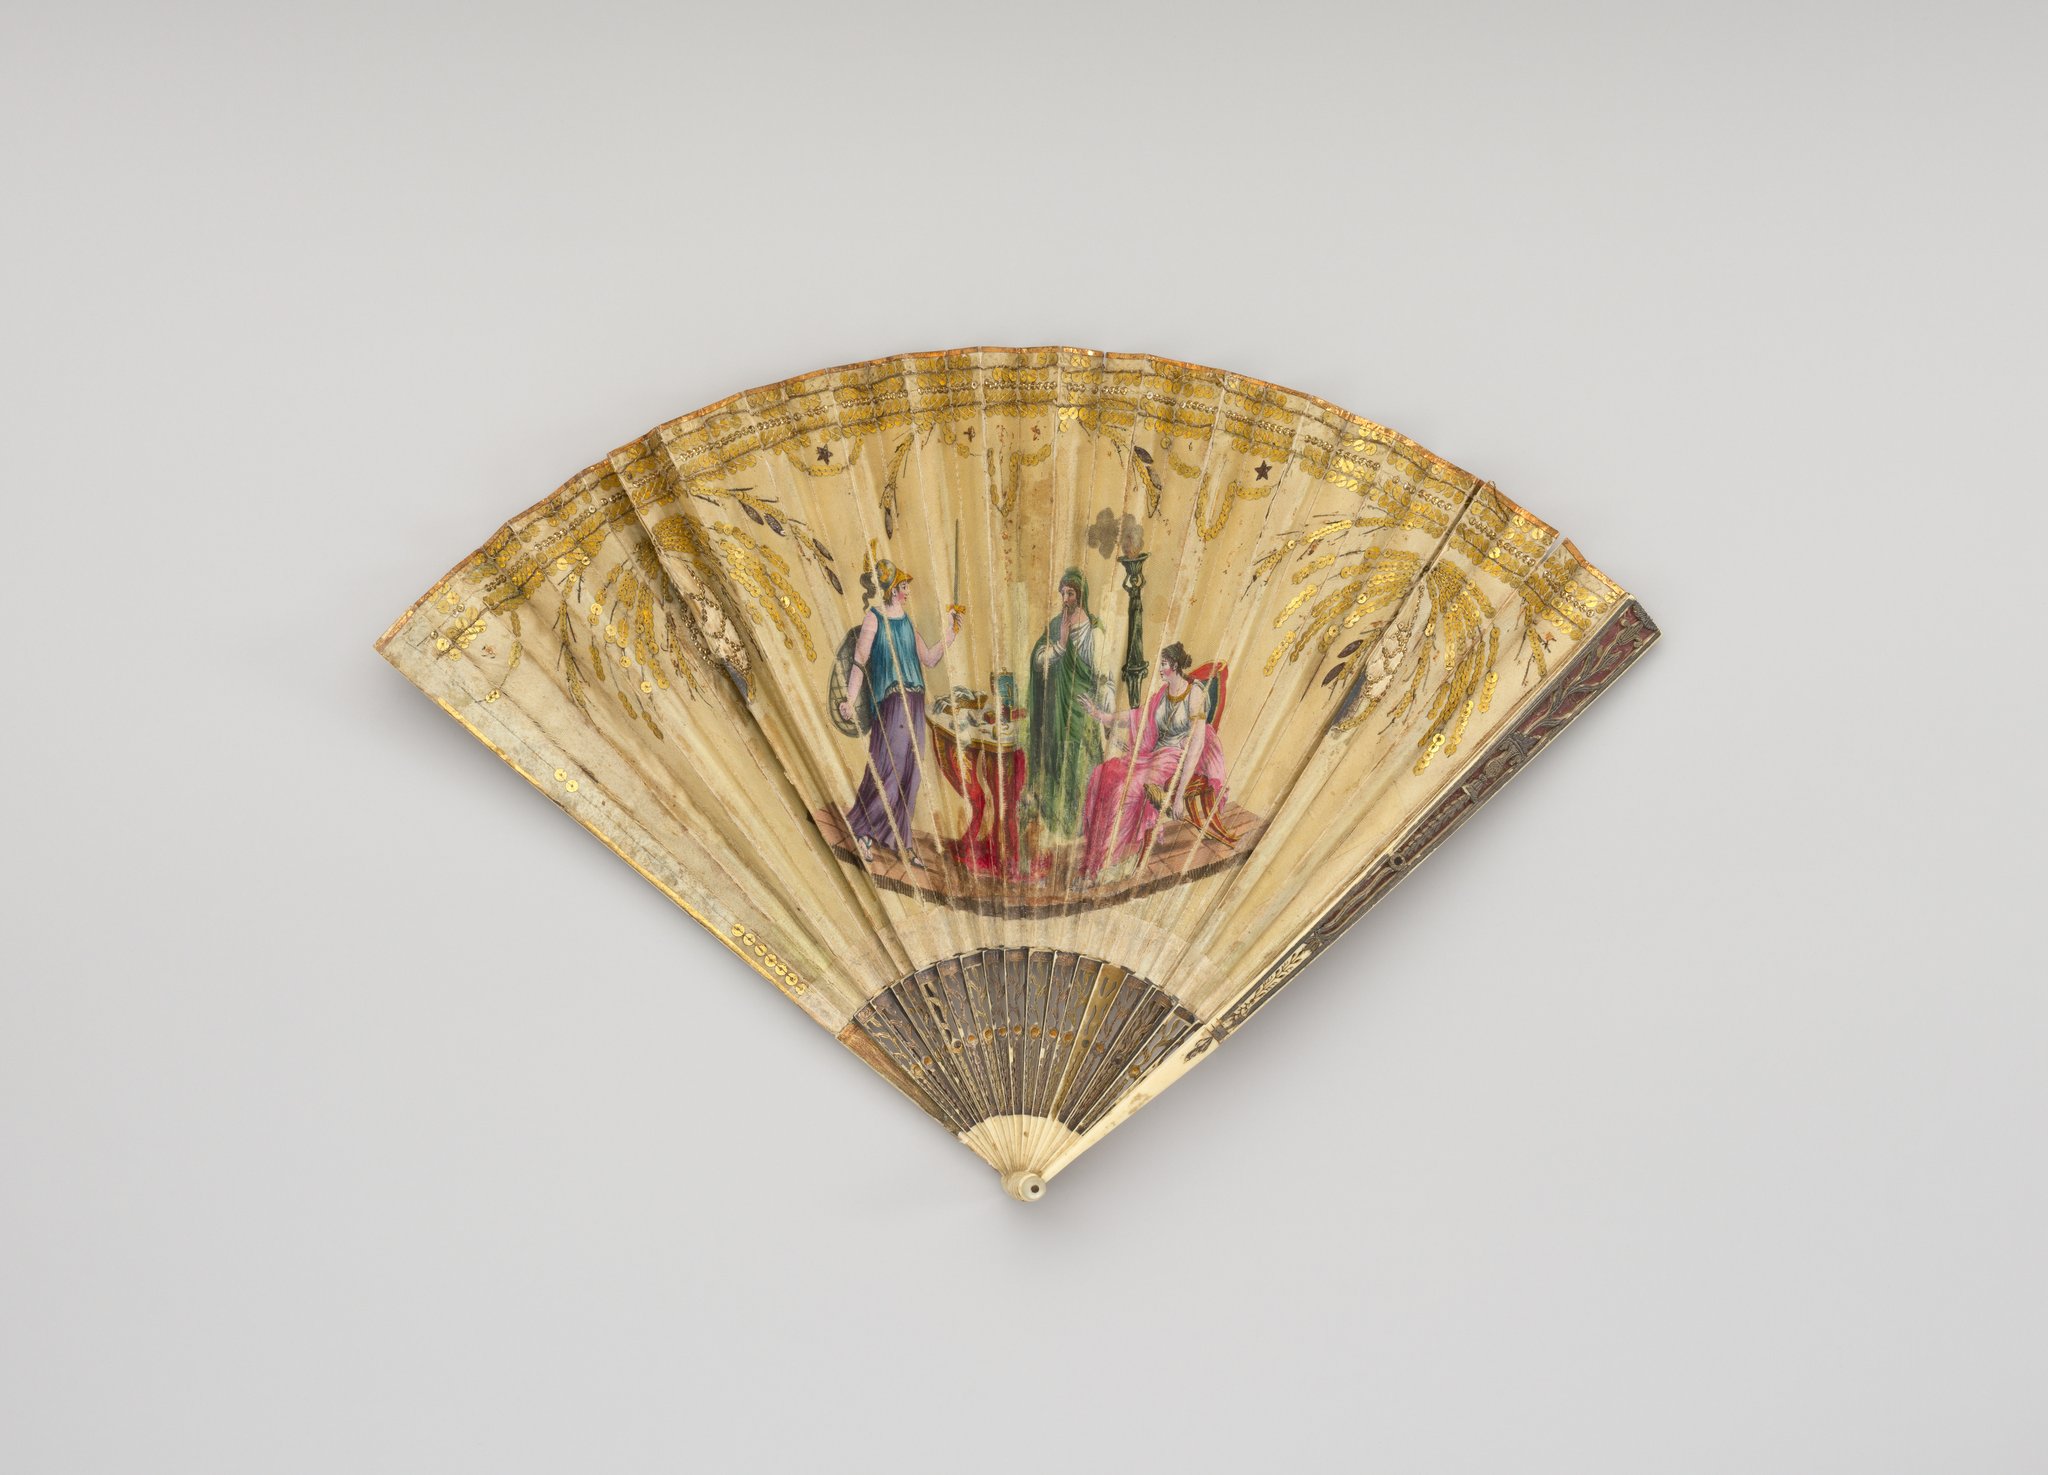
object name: fan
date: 1801-1833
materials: ivory, silk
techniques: gilding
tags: men,women